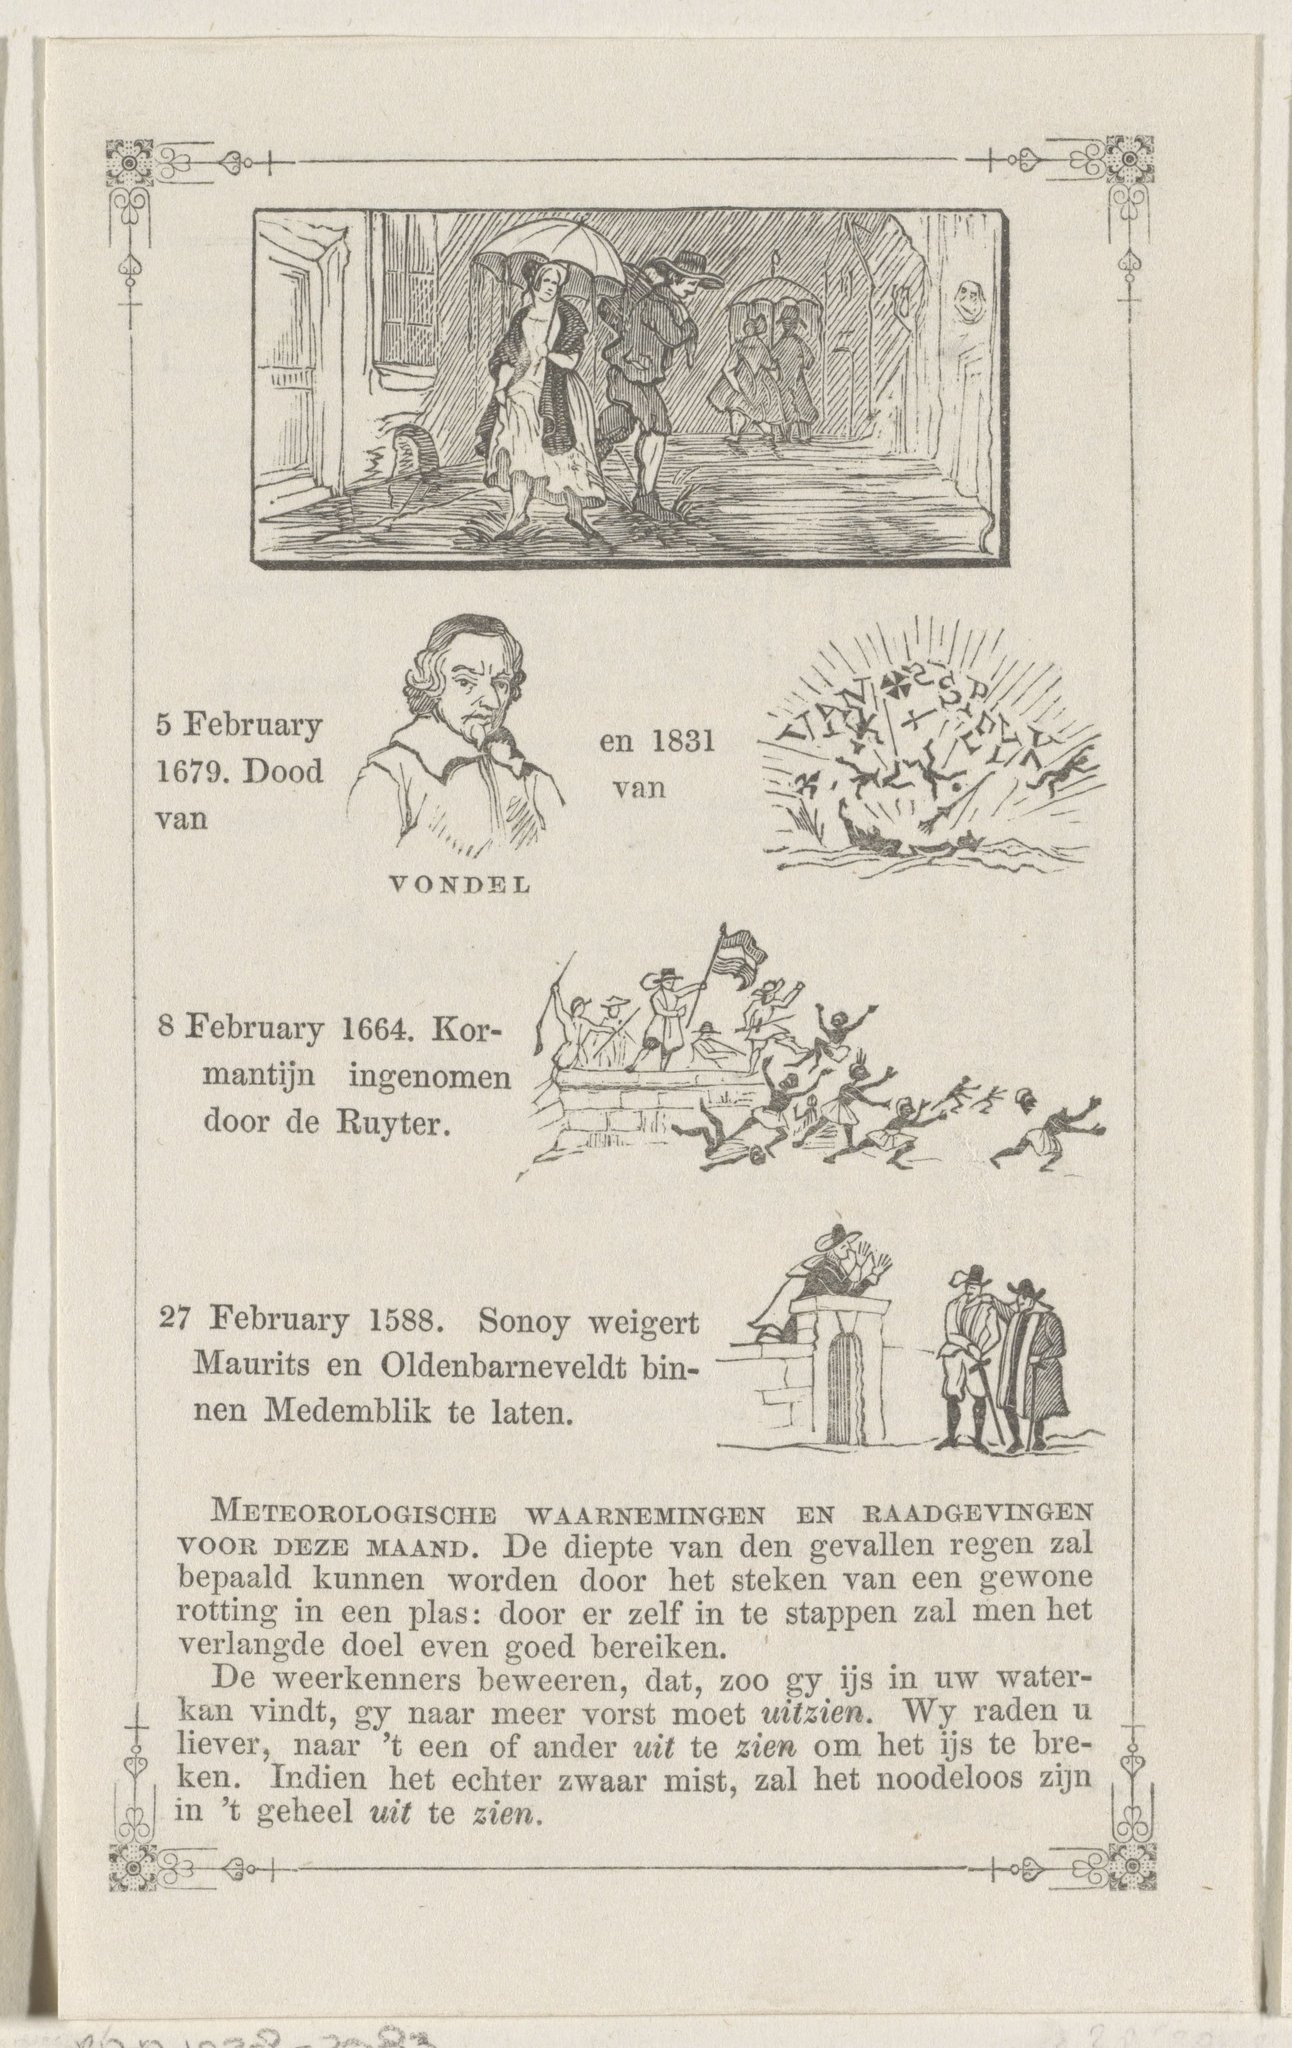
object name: print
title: Februari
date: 1849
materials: paper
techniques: letterpress printing, engraving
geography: amsterdam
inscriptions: collector's mark: Lugt 2228, collector's mark: Lugt 2760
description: Midden boven een voorstelling van figuren lopend met paraplu's in de regen. Daaronder een aantal voorstellingen van gebeurtenissen die plaatsvonden in de maand februari, waaronder de dood van Joost van den Vondel in 1679. Midden onder meteorologische waarnemingen en raadgevingen voor de maand februari in 1849.